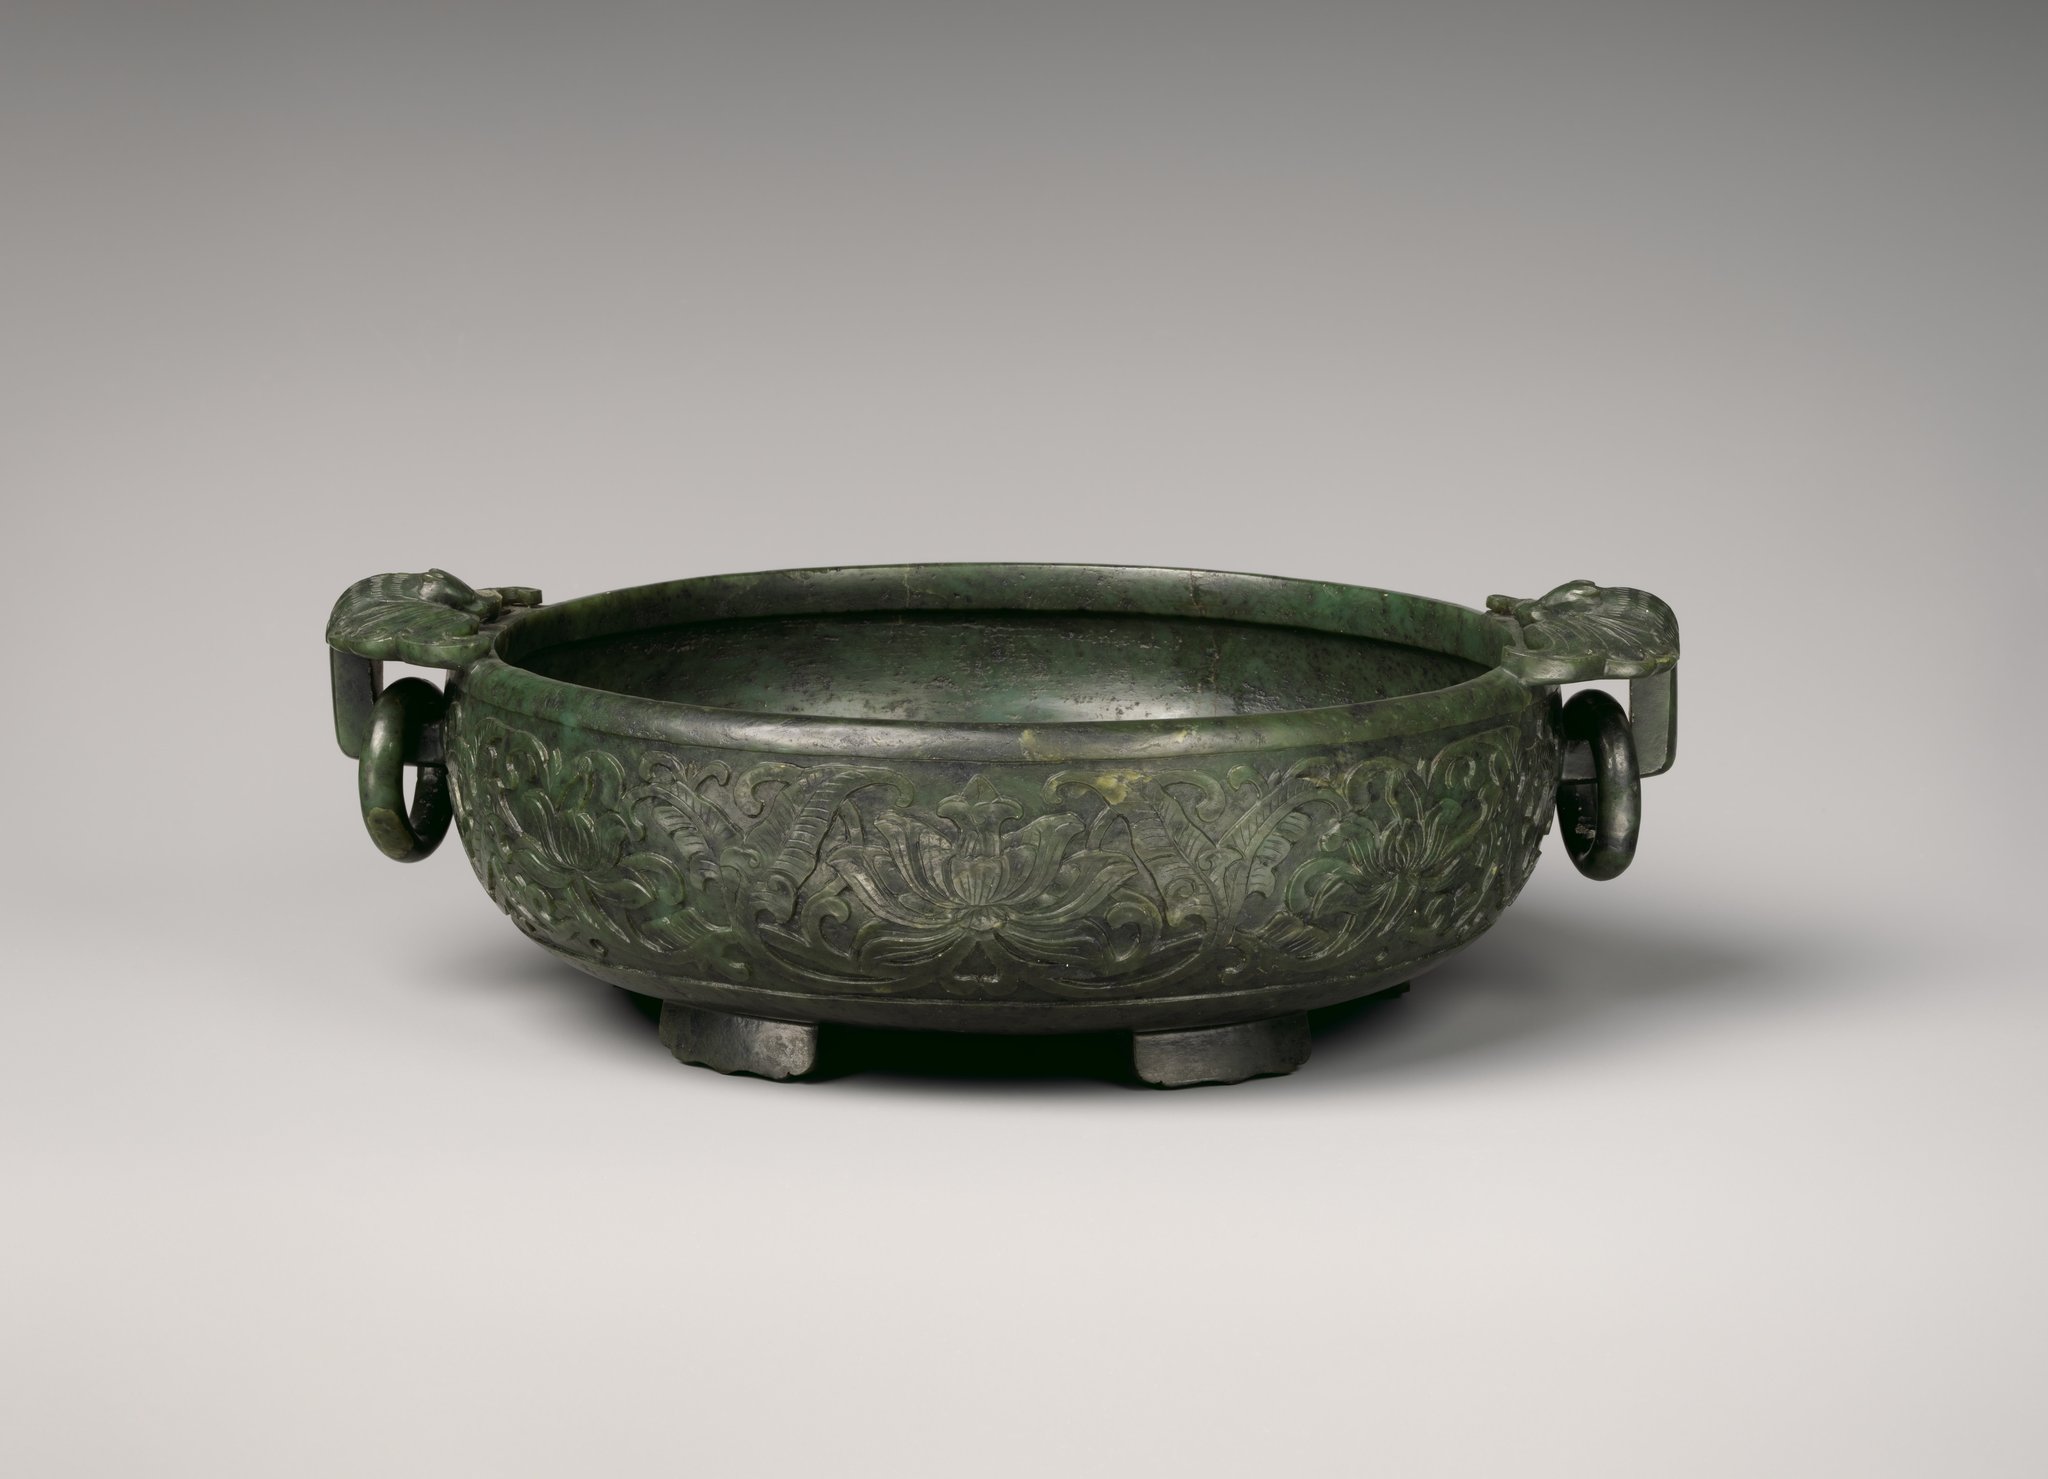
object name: bowl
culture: chinese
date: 1736-1795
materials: jade